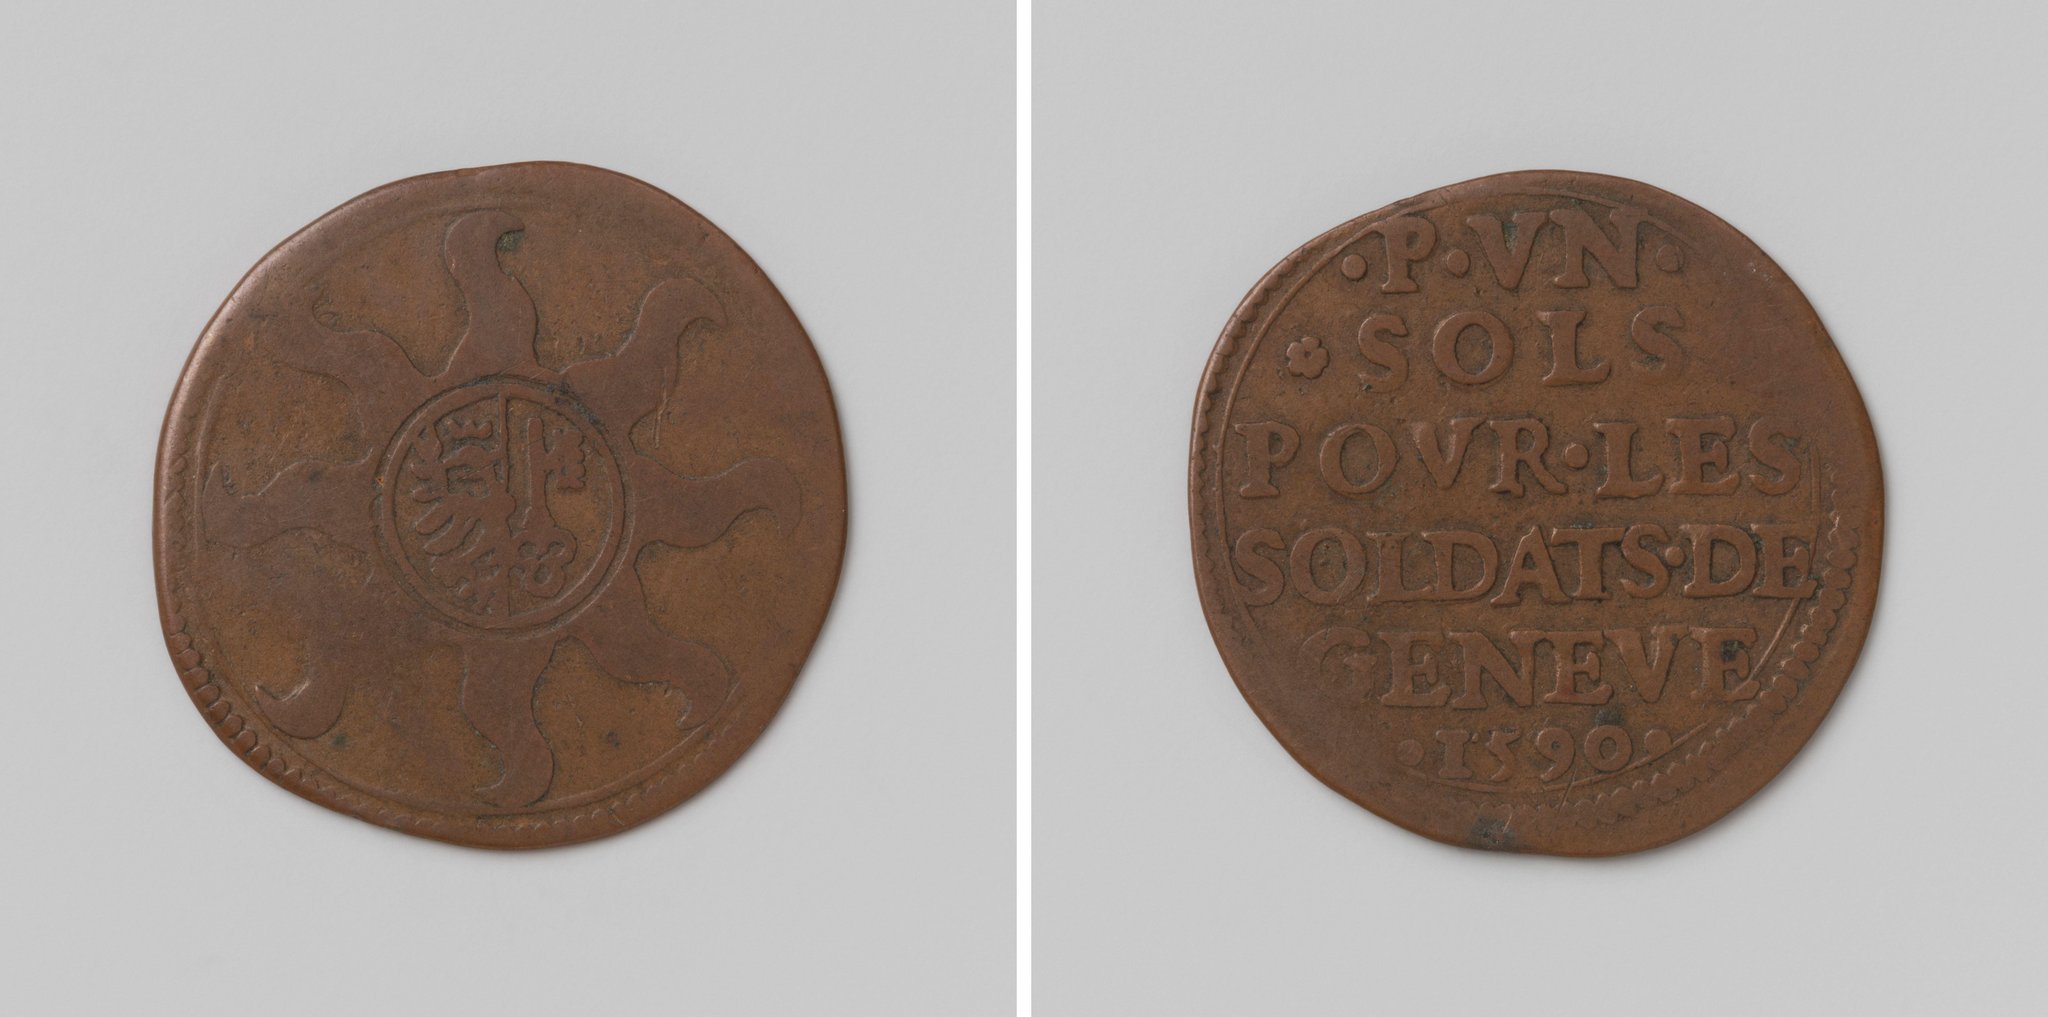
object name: coin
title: Sol, noodmunt geslagen voor de soldaten van Genève tijdens de oorlog tussen Genève en Savoie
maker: Anonymous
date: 1590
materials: copper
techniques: striking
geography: geneva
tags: genève, oorlog tussen geneve en savoie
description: Voorzijde: wapenschild in ster met acht golvende punten. Keerzijde: opschrift